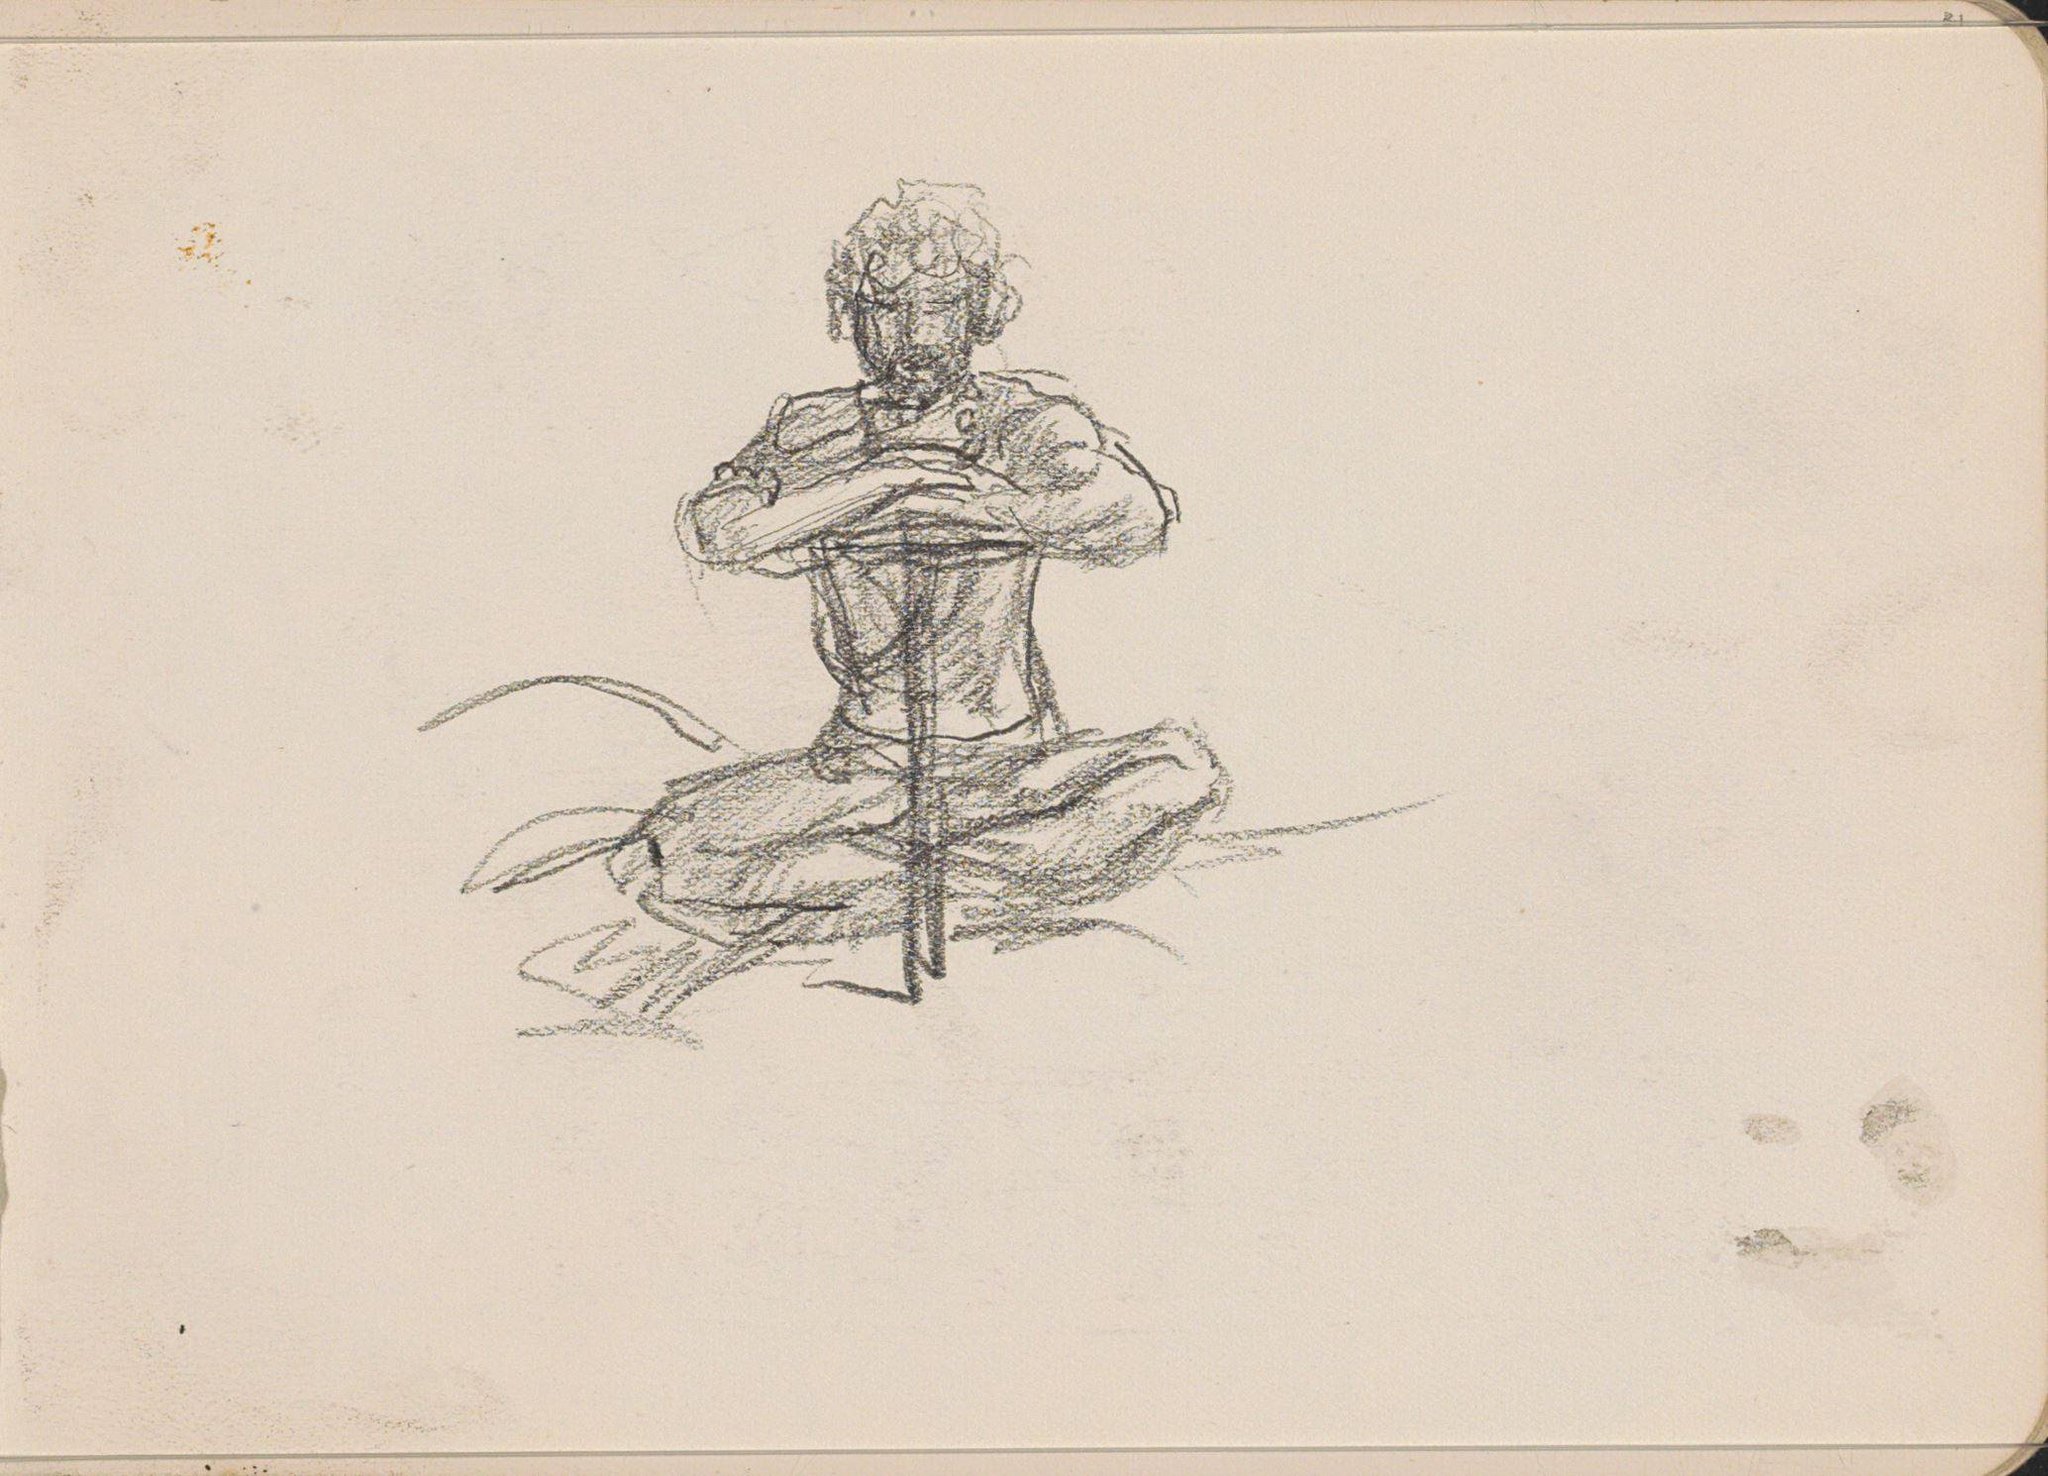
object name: sketchbook leaf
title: Zittende Indiër, met de armen gekruist op een stok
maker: marius bauer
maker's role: draughtsman, print maker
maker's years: 1867-1932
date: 1924-1925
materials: paper, pencil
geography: india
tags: sitting figure, walking-stick, staff, adult man, necklace, asiatic races and peoples: indians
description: De man heeft het bovenlijf ontbloot en draagt een halsketting. Pagina 21 uit een schetsboek met 23 bladen.